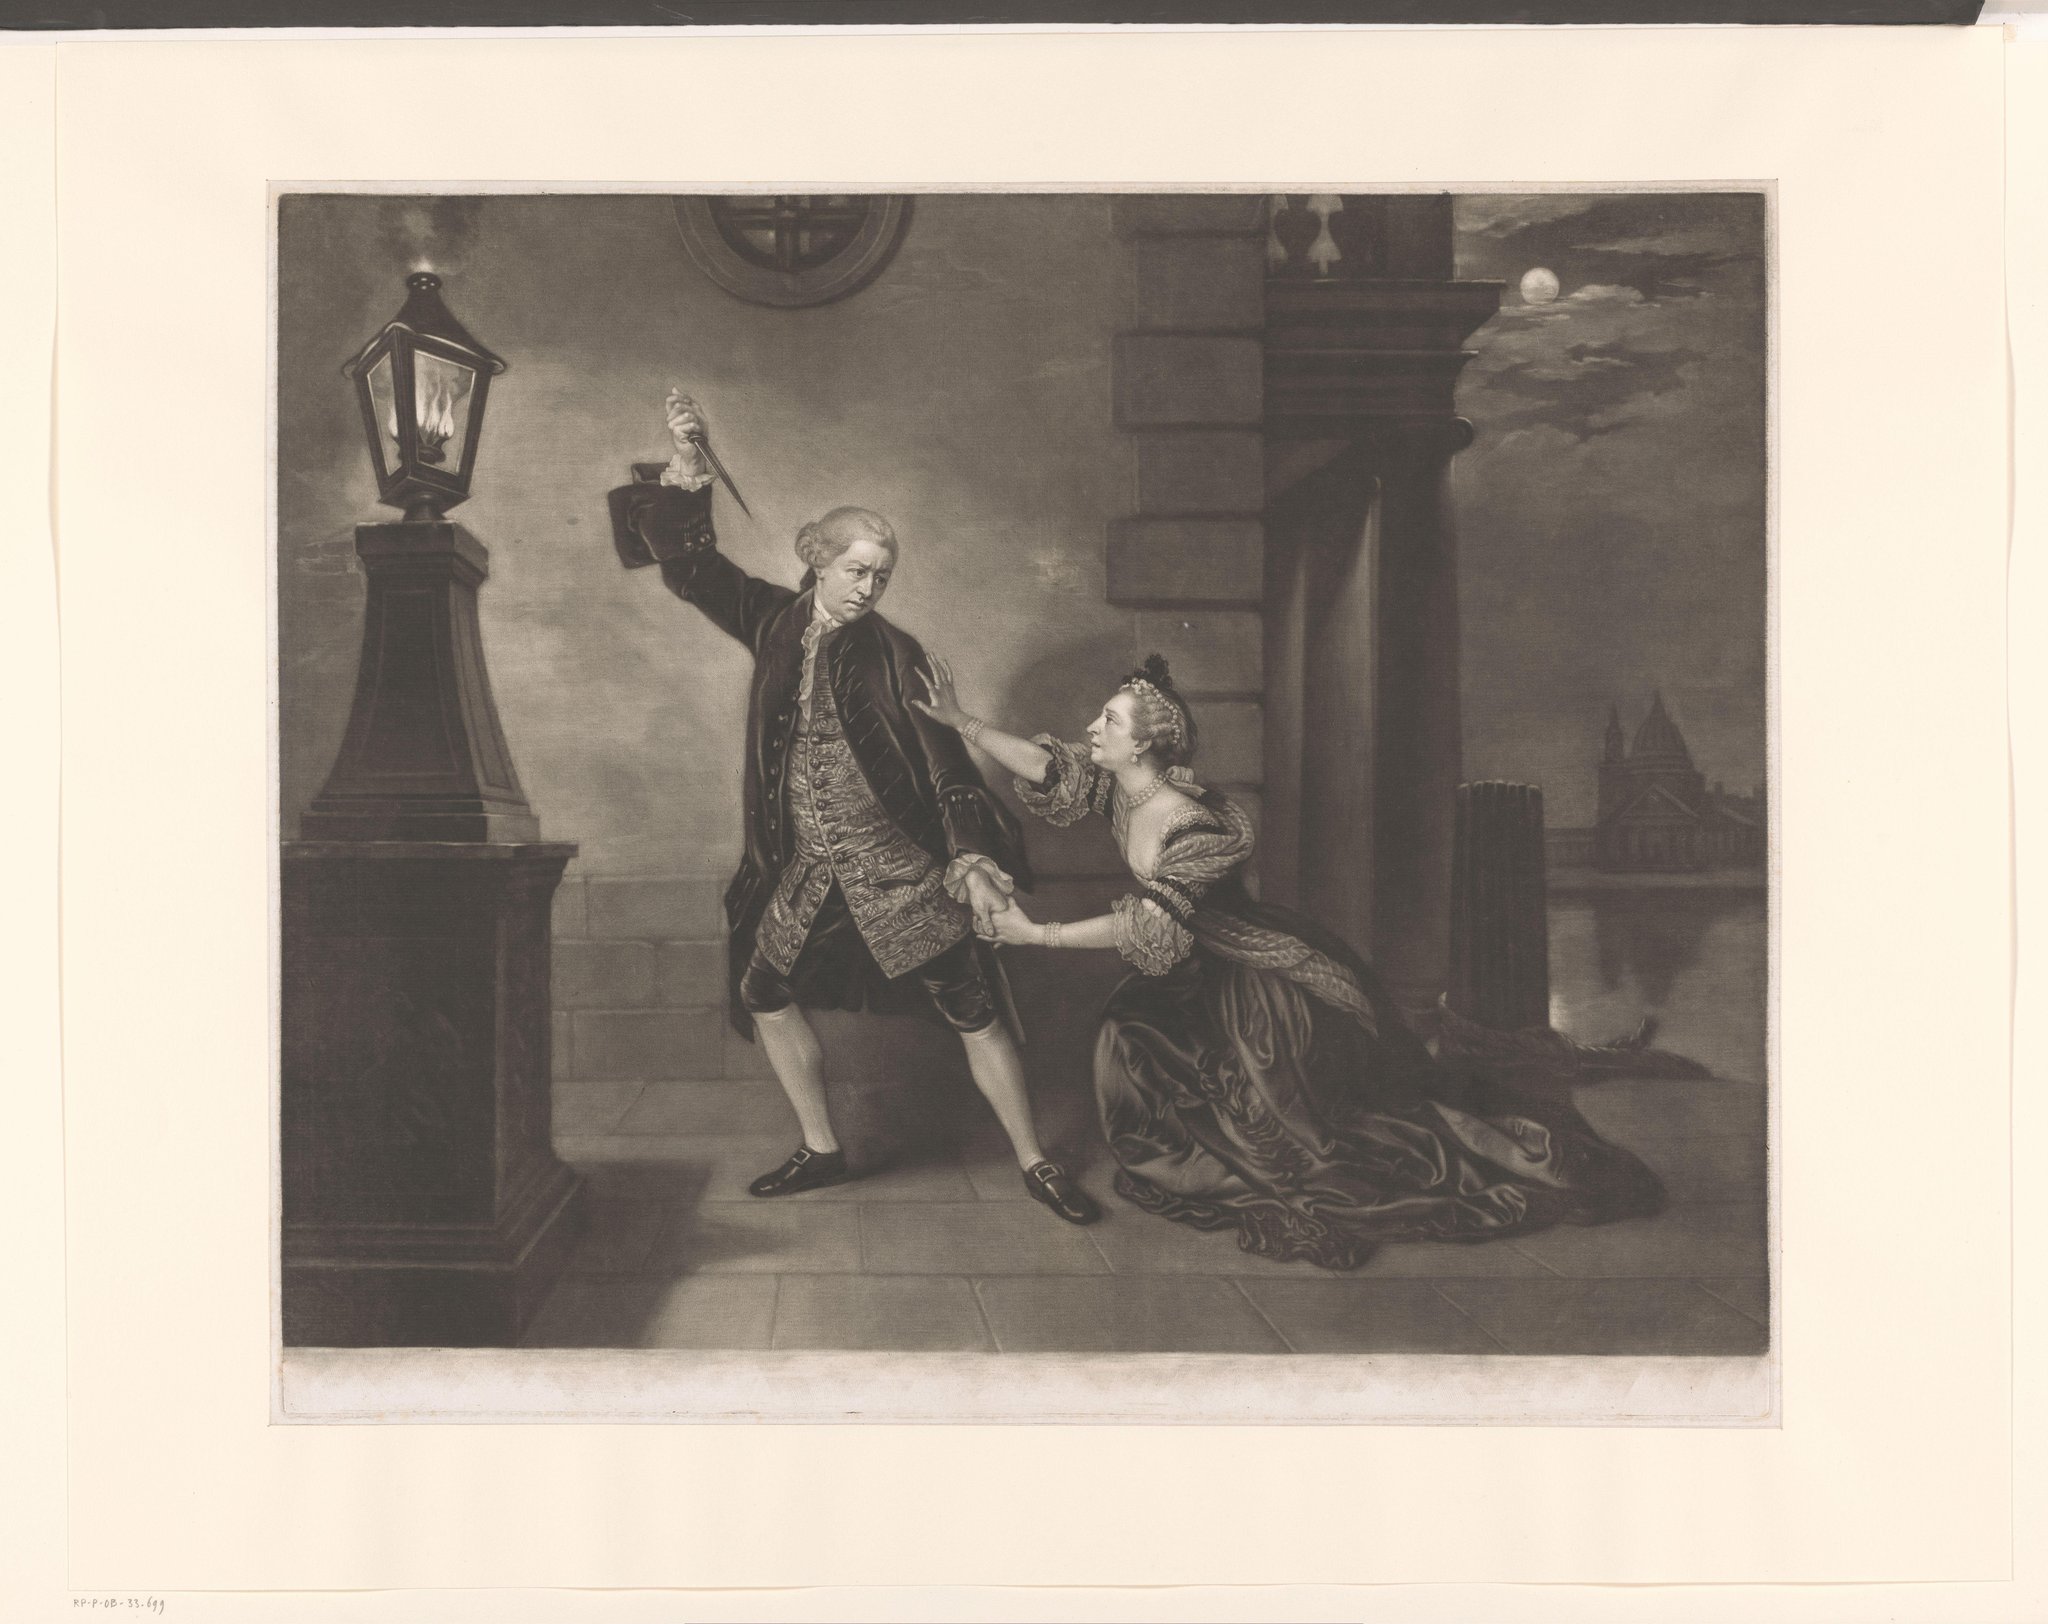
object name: print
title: Portret van David Garrick en Susannah Maria Cibber als Jaffier en Belvidera in 'Venice Preserved'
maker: james mcardell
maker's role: print maker, publisher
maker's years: 1728-1765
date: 1764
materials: paper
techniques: mezzotint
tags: david garrick, portrait of actor, actress (+ artist at work), historical persons - bb - woman, historical persons, actress (on the stage), actor (on the stage)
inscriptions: collector's mark: Lugt 240